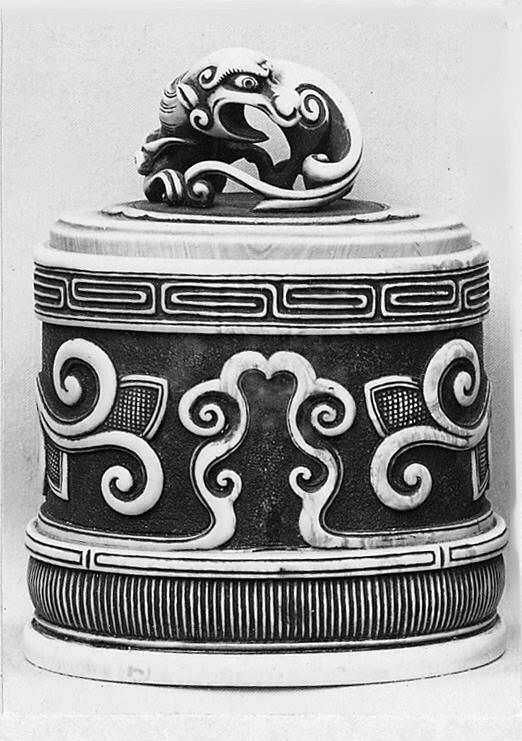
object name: tobacco box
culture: japanese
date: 1801-1900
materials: ivory